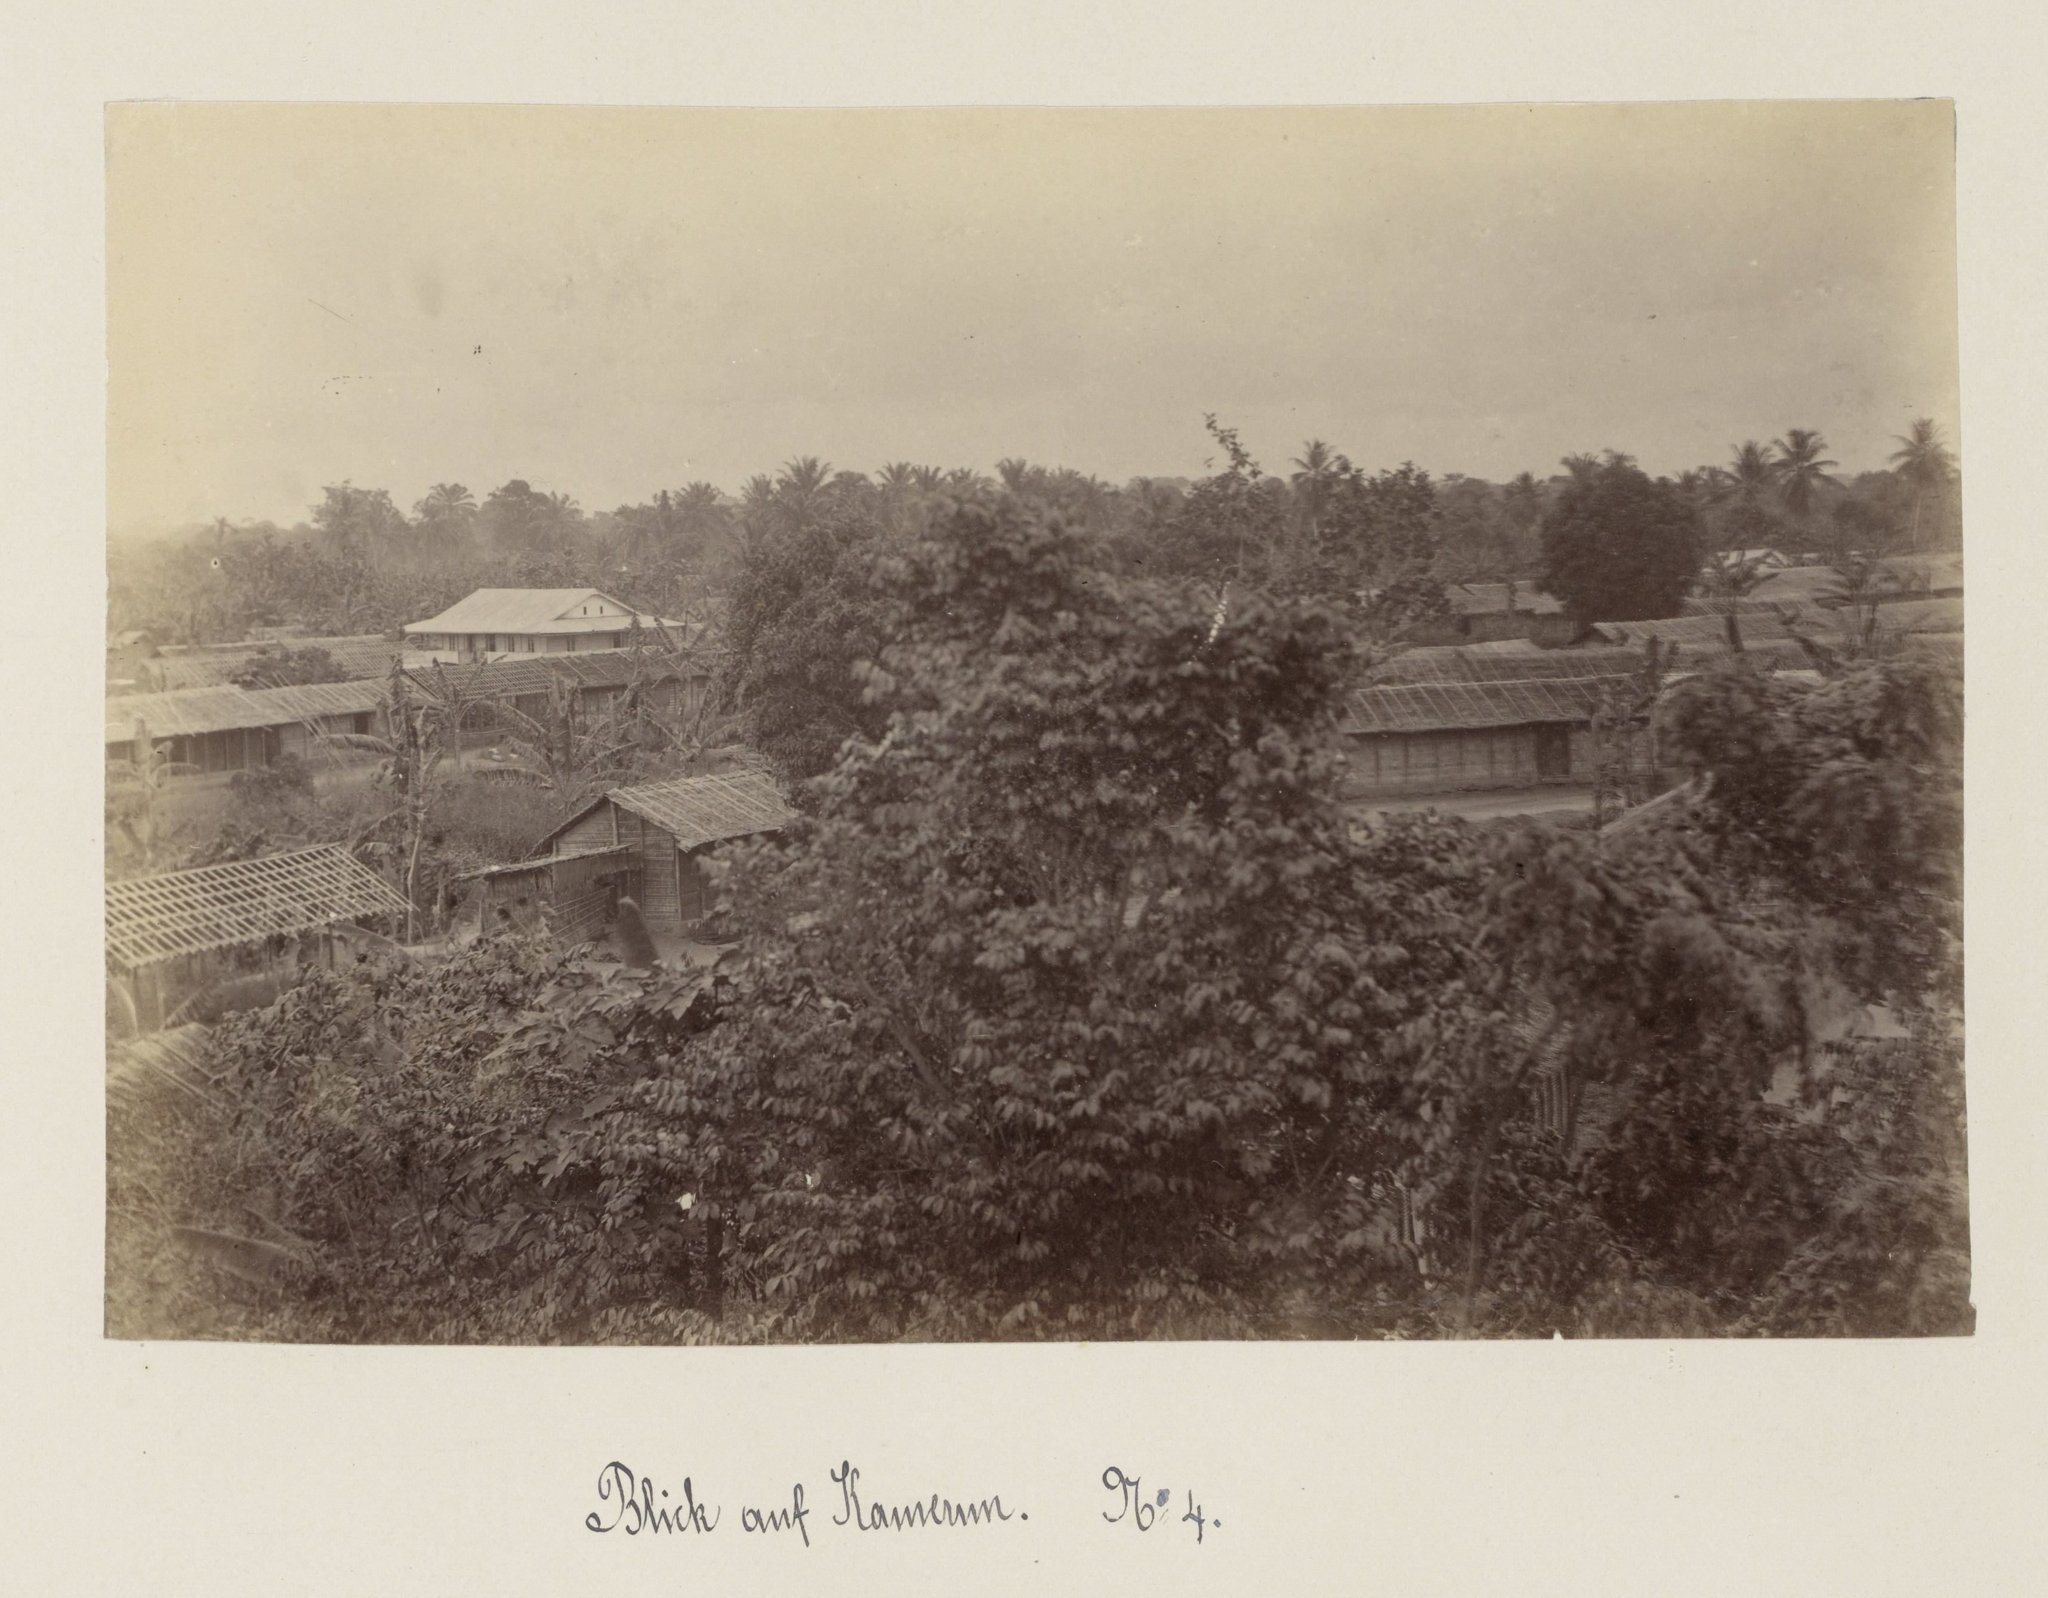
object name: panoramic photograph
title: Gezicht op de omgeving van een gouvernementsgebouw in Kameroen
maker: Anonymous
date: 1899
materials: photographic support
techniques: albumen print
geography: cameroon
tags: prospect of village, silhouette of village, forest, wood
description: Foto 4 van een panorama van 4. Onderdeel van Fotoalbum met opnames van Kameroen rond 1899.